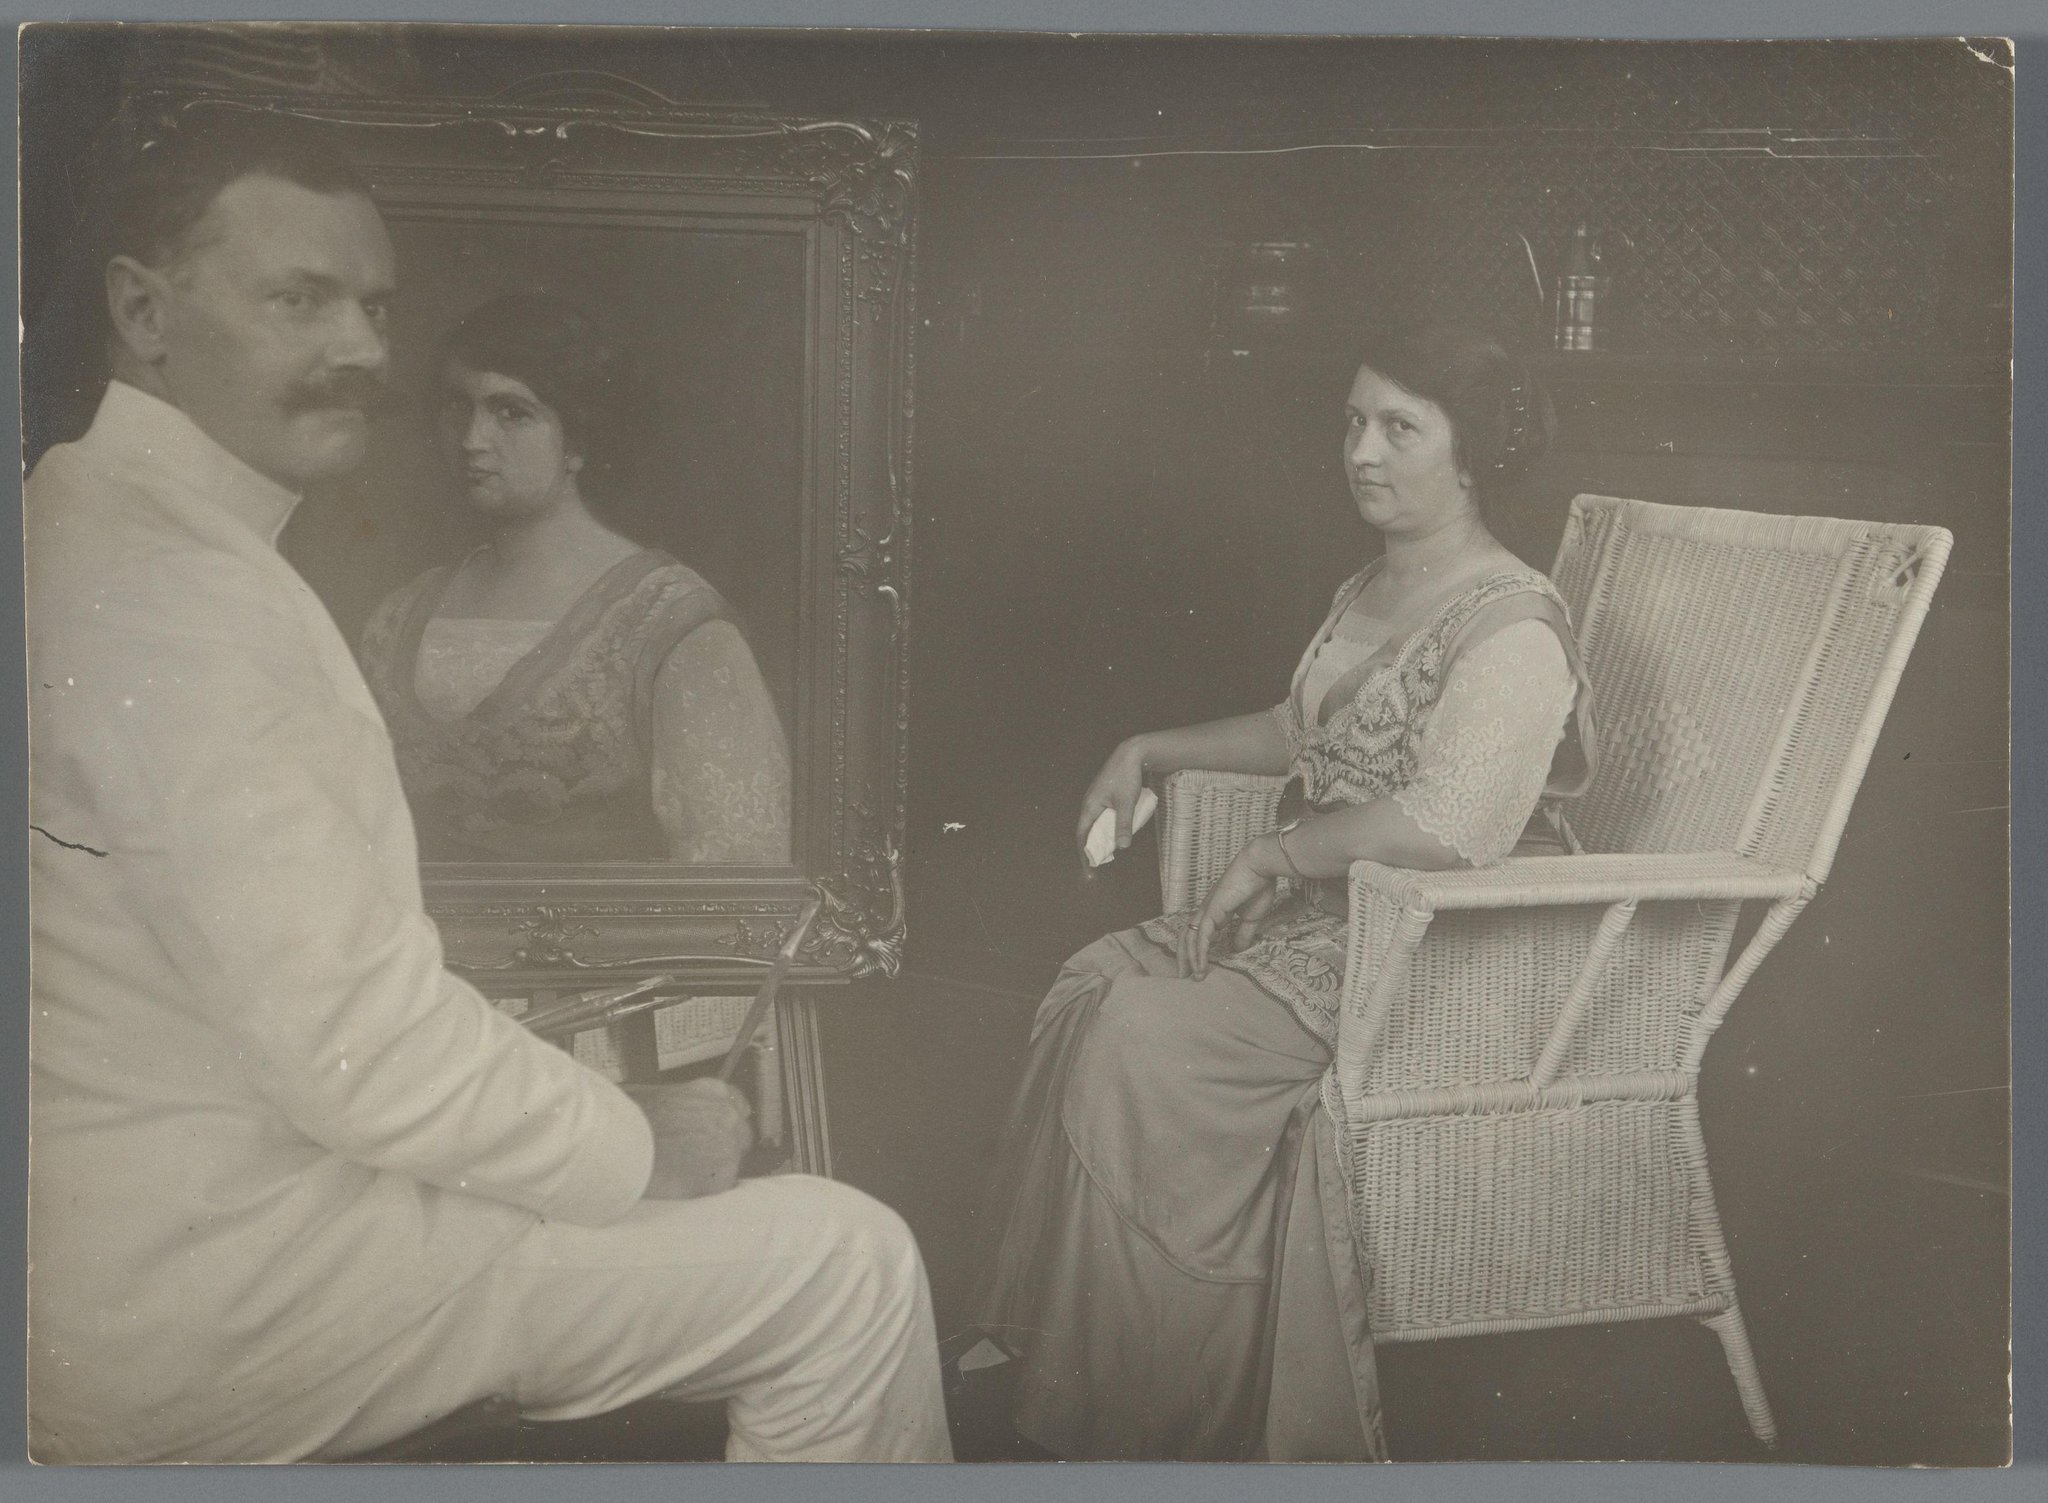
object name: photograph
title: Théodore van Lelyveld achter de ezel portretteert mevrouw Le Lorrain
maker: théodore van lelyveld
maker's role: painter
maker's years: 1867-1954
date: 1913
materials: photographic support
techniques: gelatin silver print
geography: dutch east indies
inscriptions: annotation: ‘Aletta van Tijen Medan 1913’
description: Théodore van Lelyveld achter de ezel portretteert mevrouw Le Lorrain te Bekioen Deli.